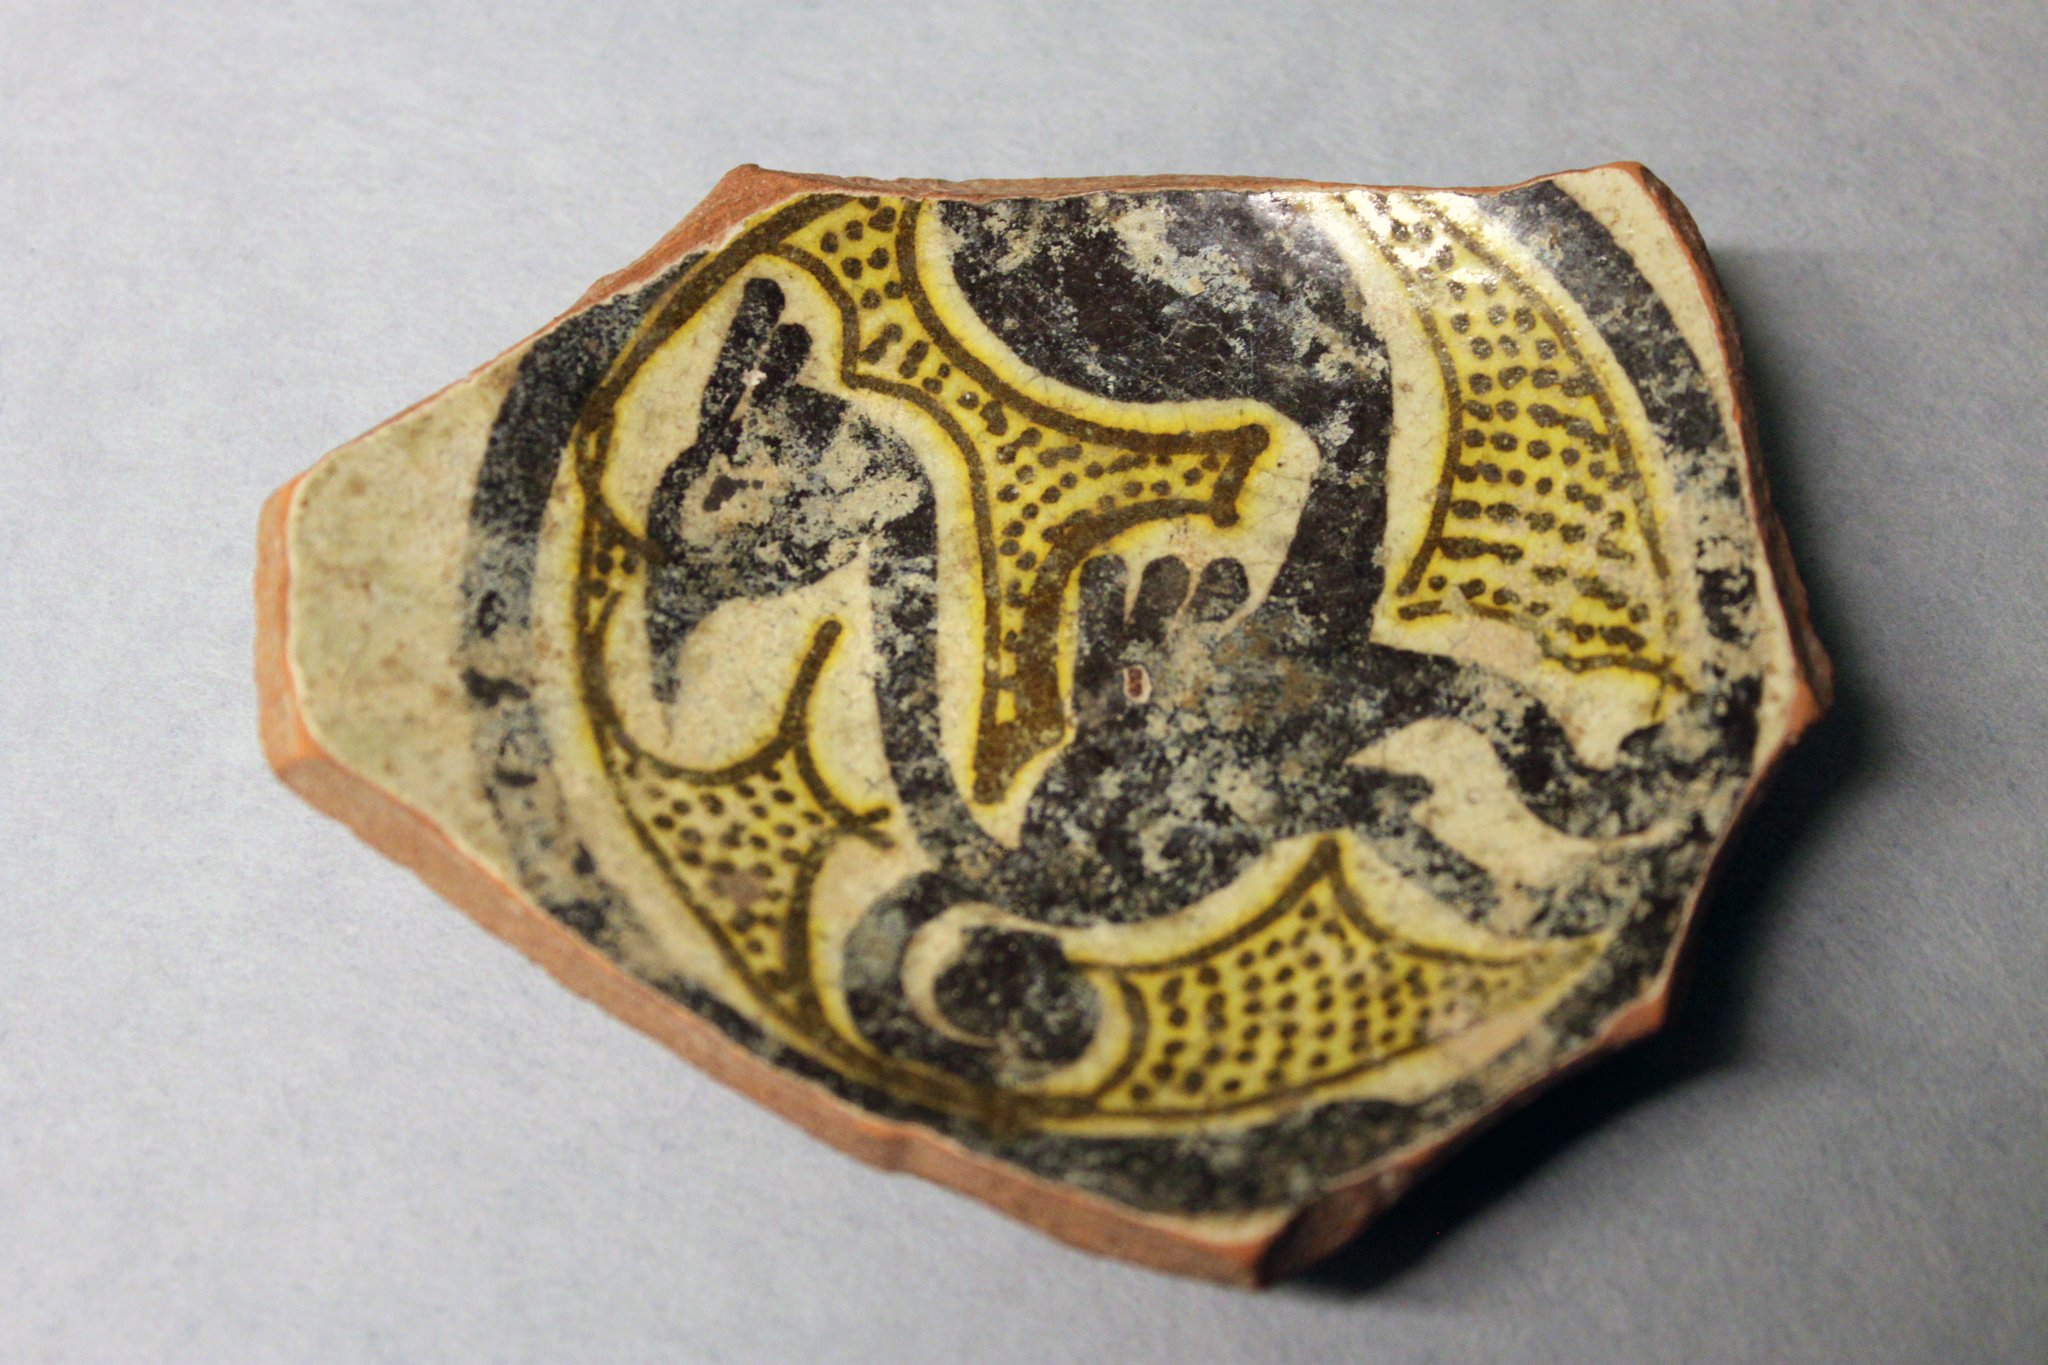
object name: fragment of a bowl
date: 801-1000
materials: earthenware, glaze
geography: iran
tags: birds